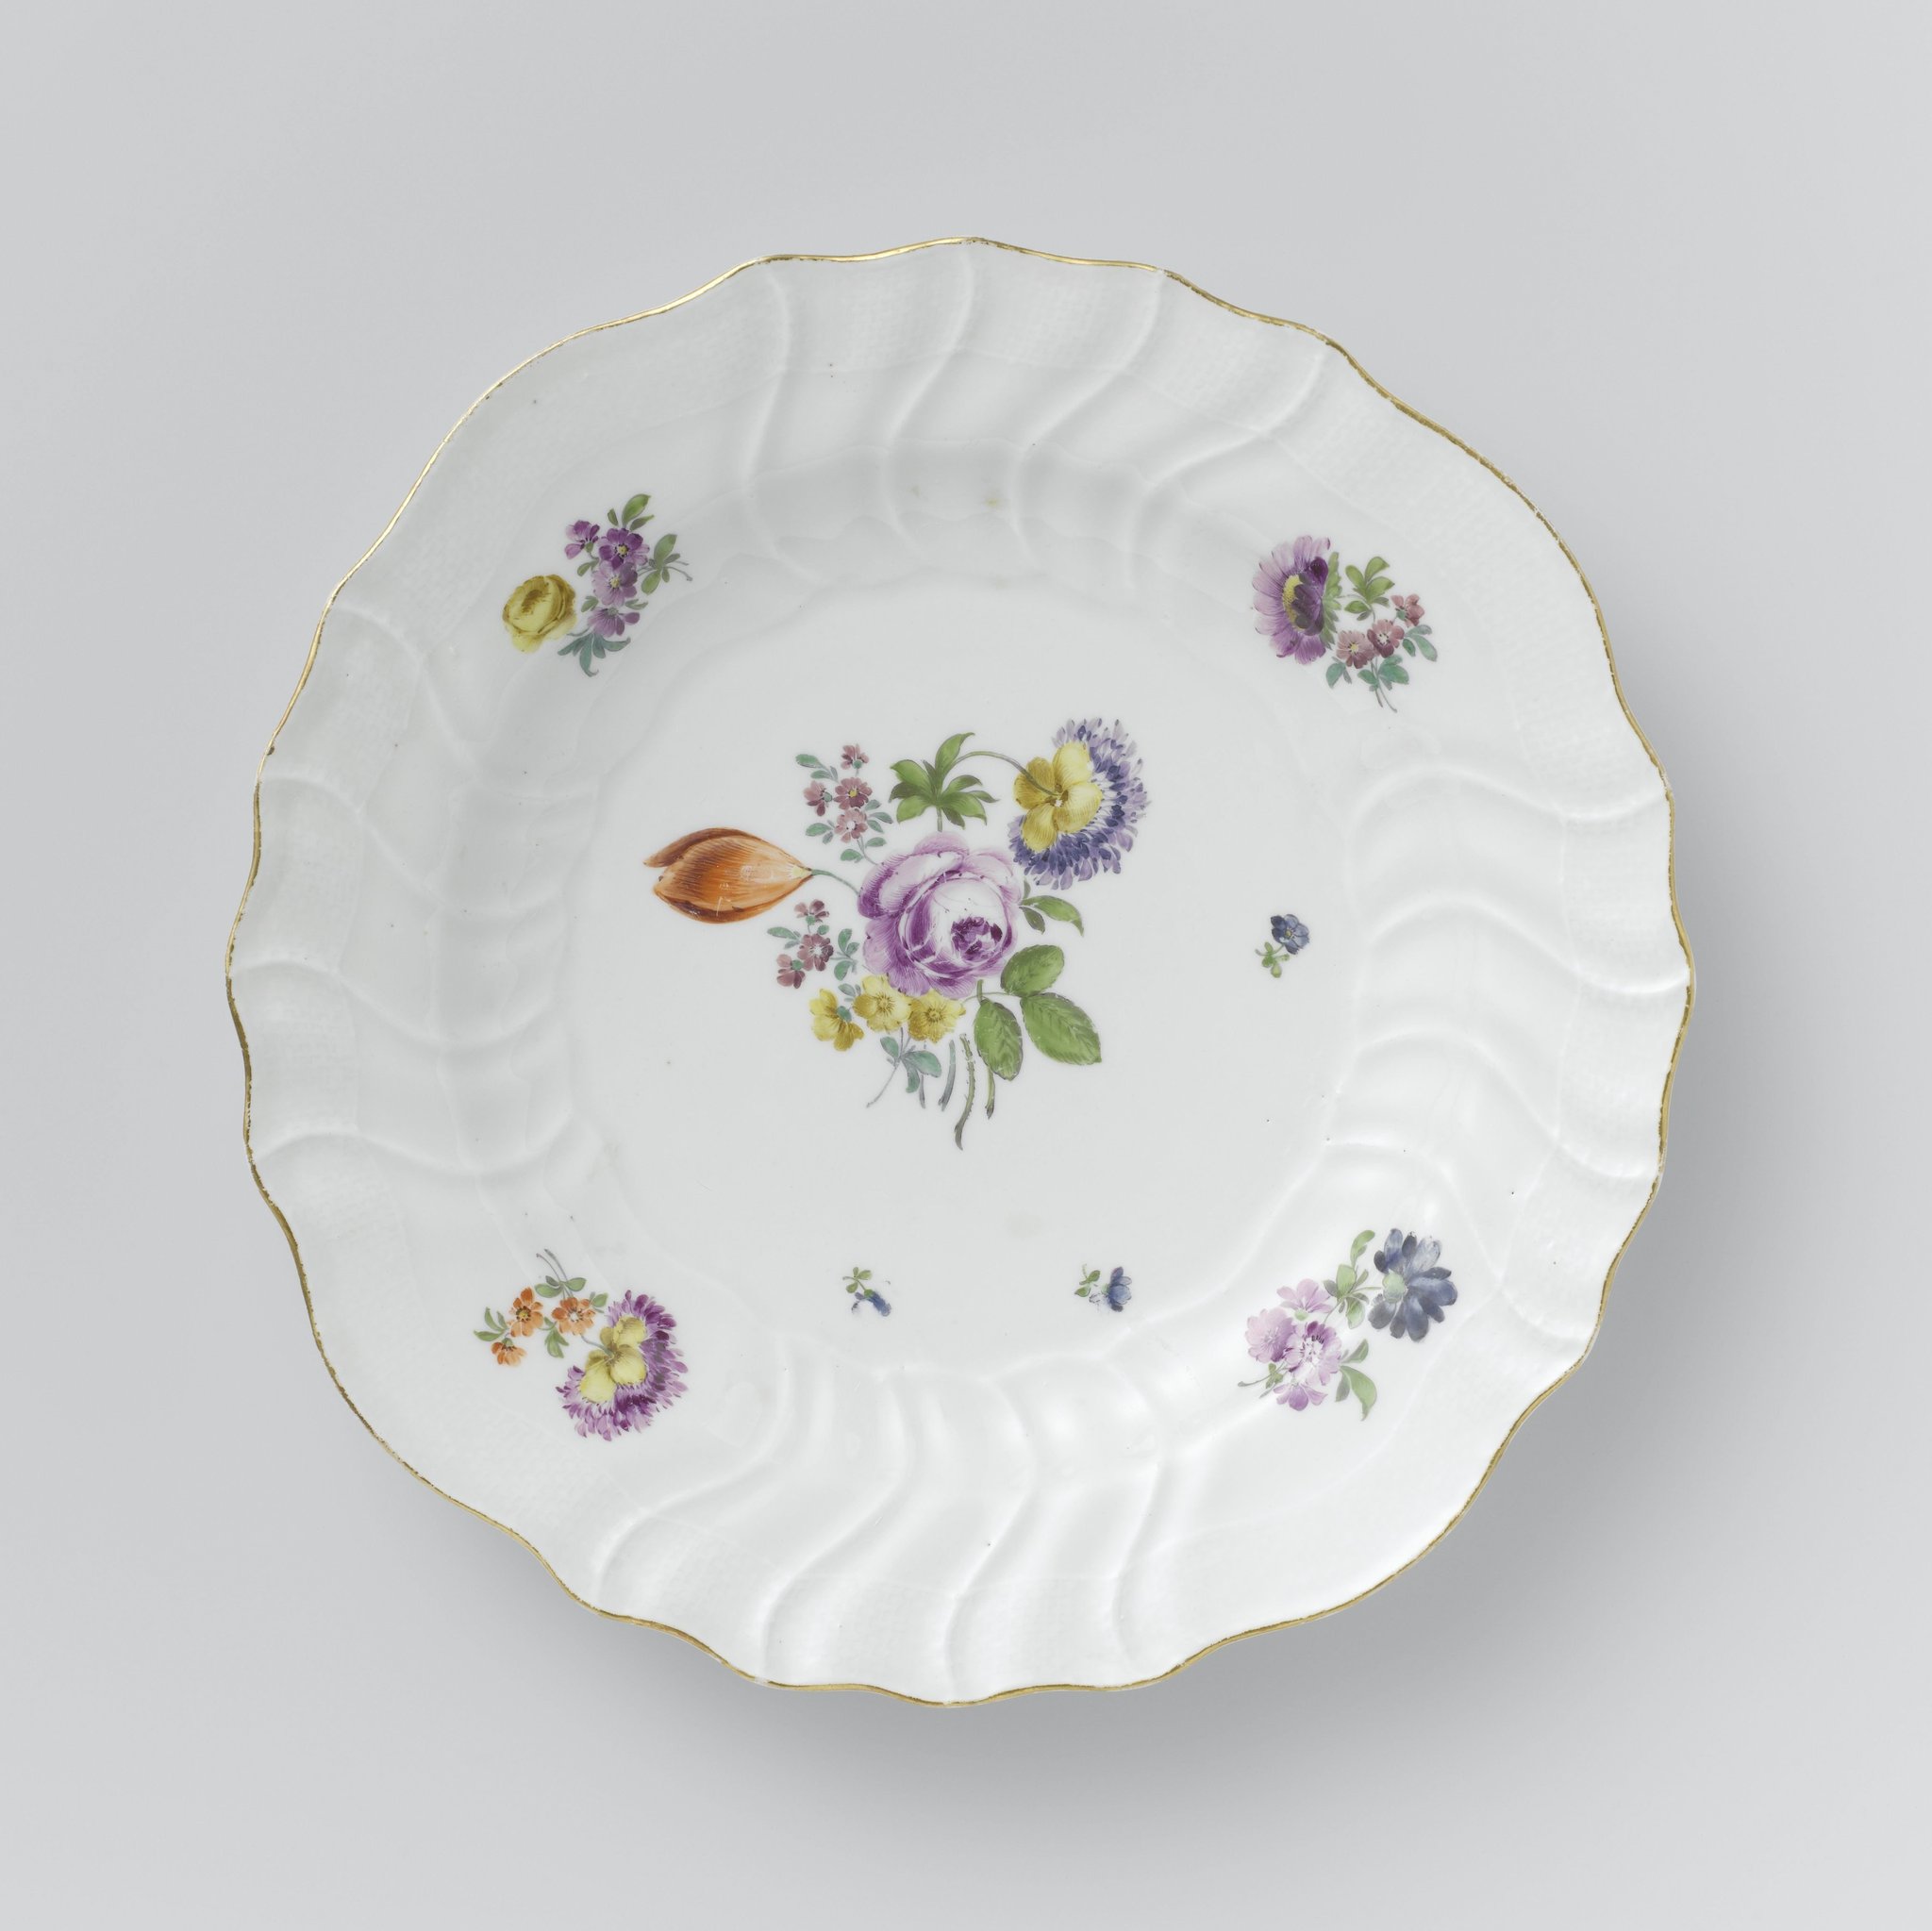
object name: plate dish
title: Bord, veelkleurig beschilderd met Deutsche Blumen, insekten en vruchten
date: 1750-1760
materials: porcelain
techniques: painted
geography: meissen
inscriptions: factory mark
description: Rond bord van beschilderd porselein. De rand is versierd met het Neuozier-patroon. De beschildering bestaat uit Deutsche Blumen, insekten en vruchten. Het bord is gemerkt en hoort bij een servies (BK-17474-1 t/m BK-17474-253).